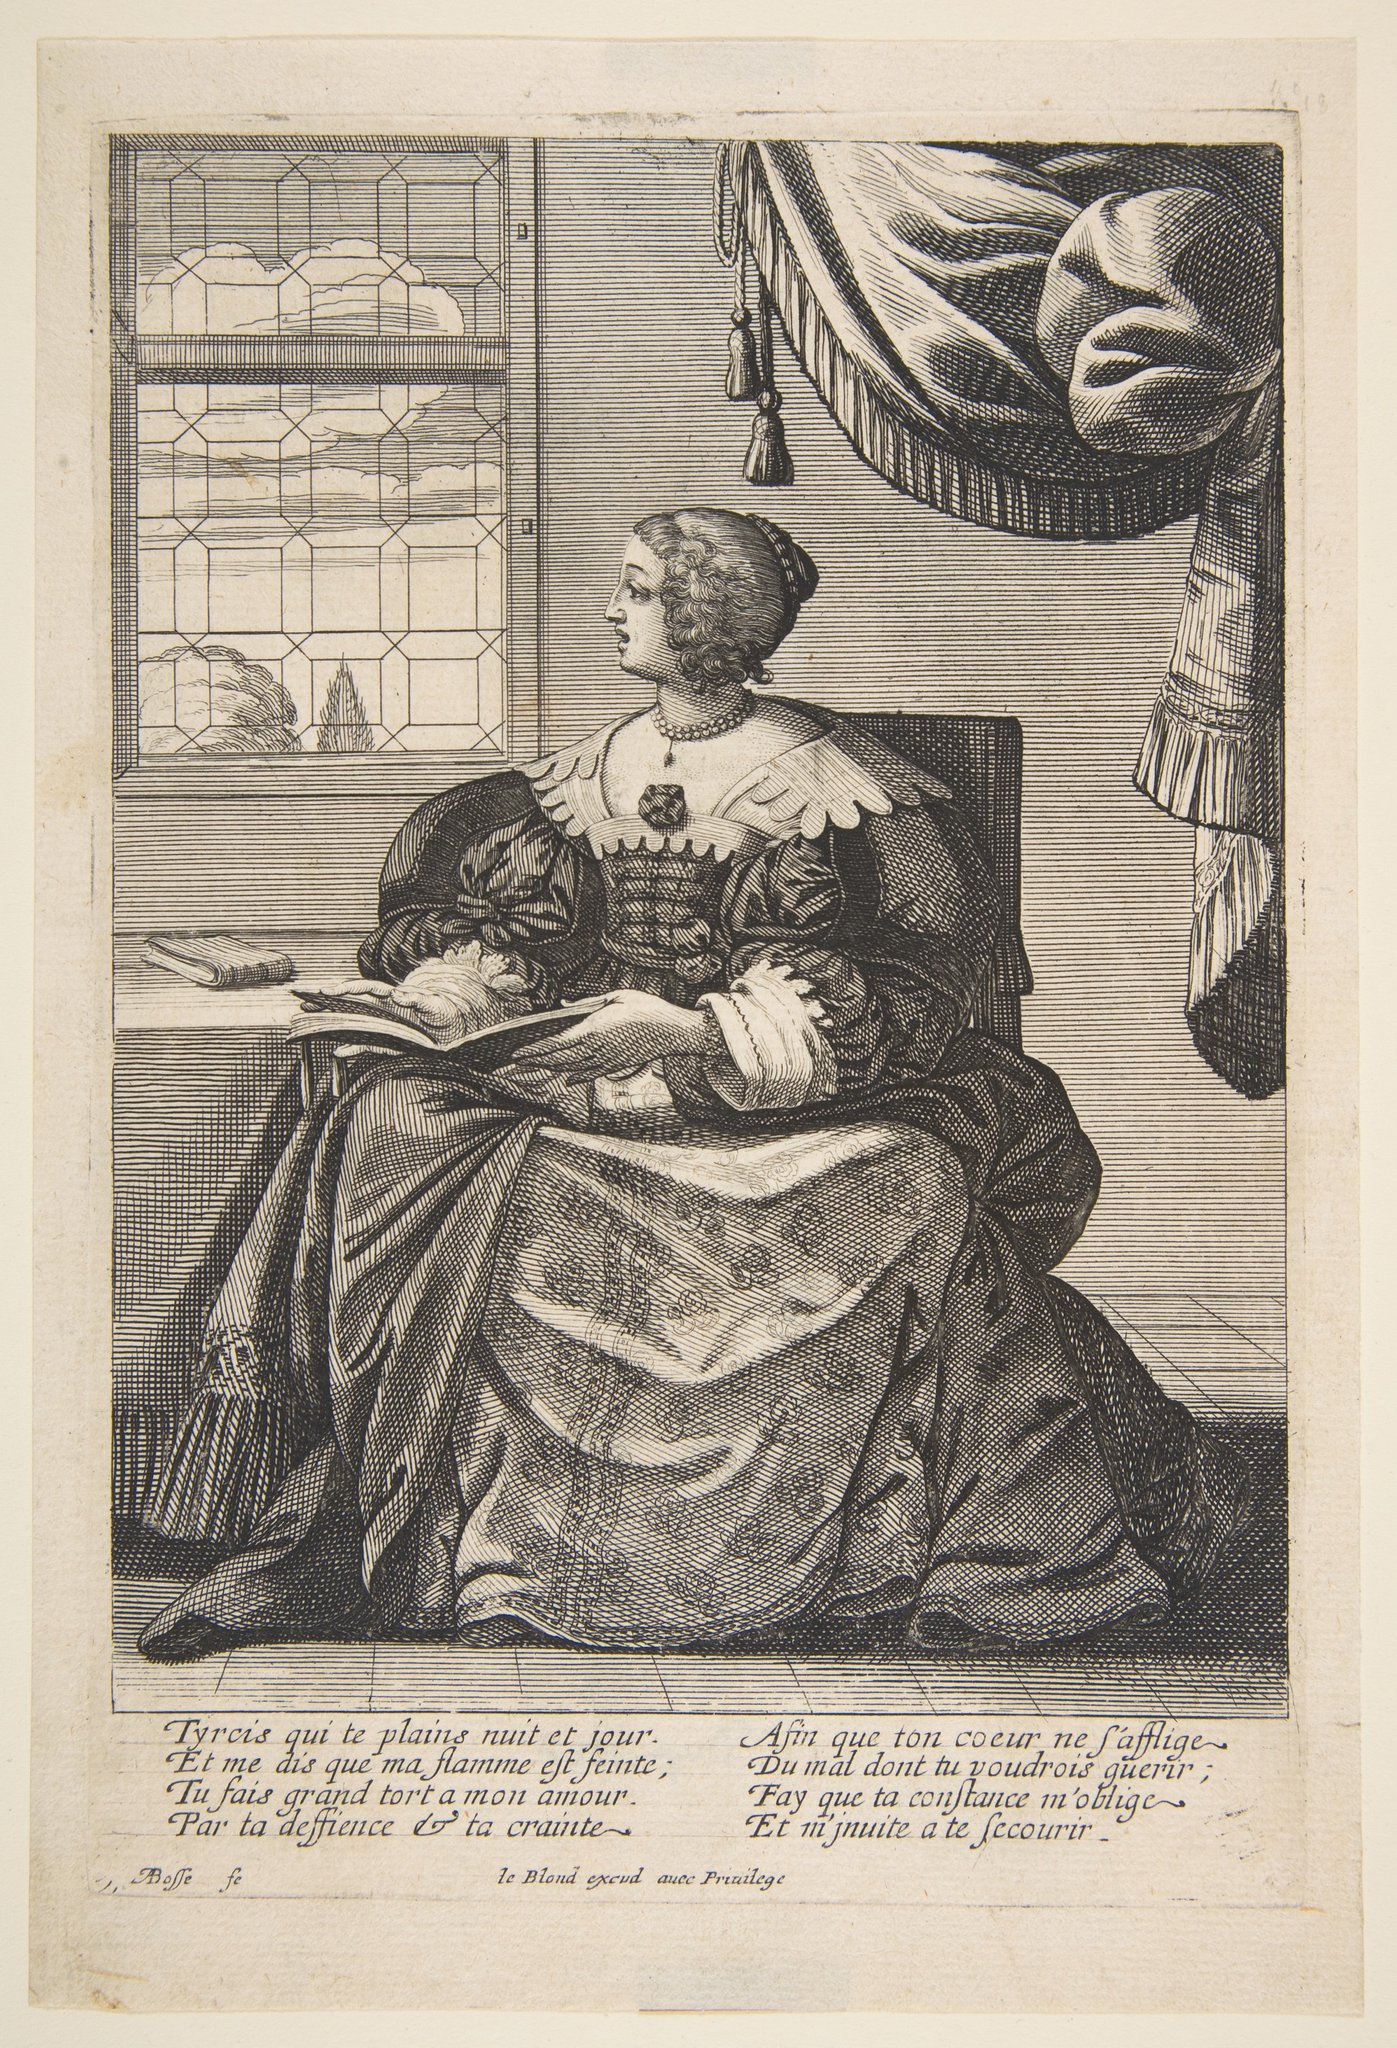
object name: print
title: Seated Woman Holding a Book and Singing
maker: abraham bosse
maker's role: artist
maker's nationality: french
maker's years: 1602-1676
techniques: etching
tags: women,singing